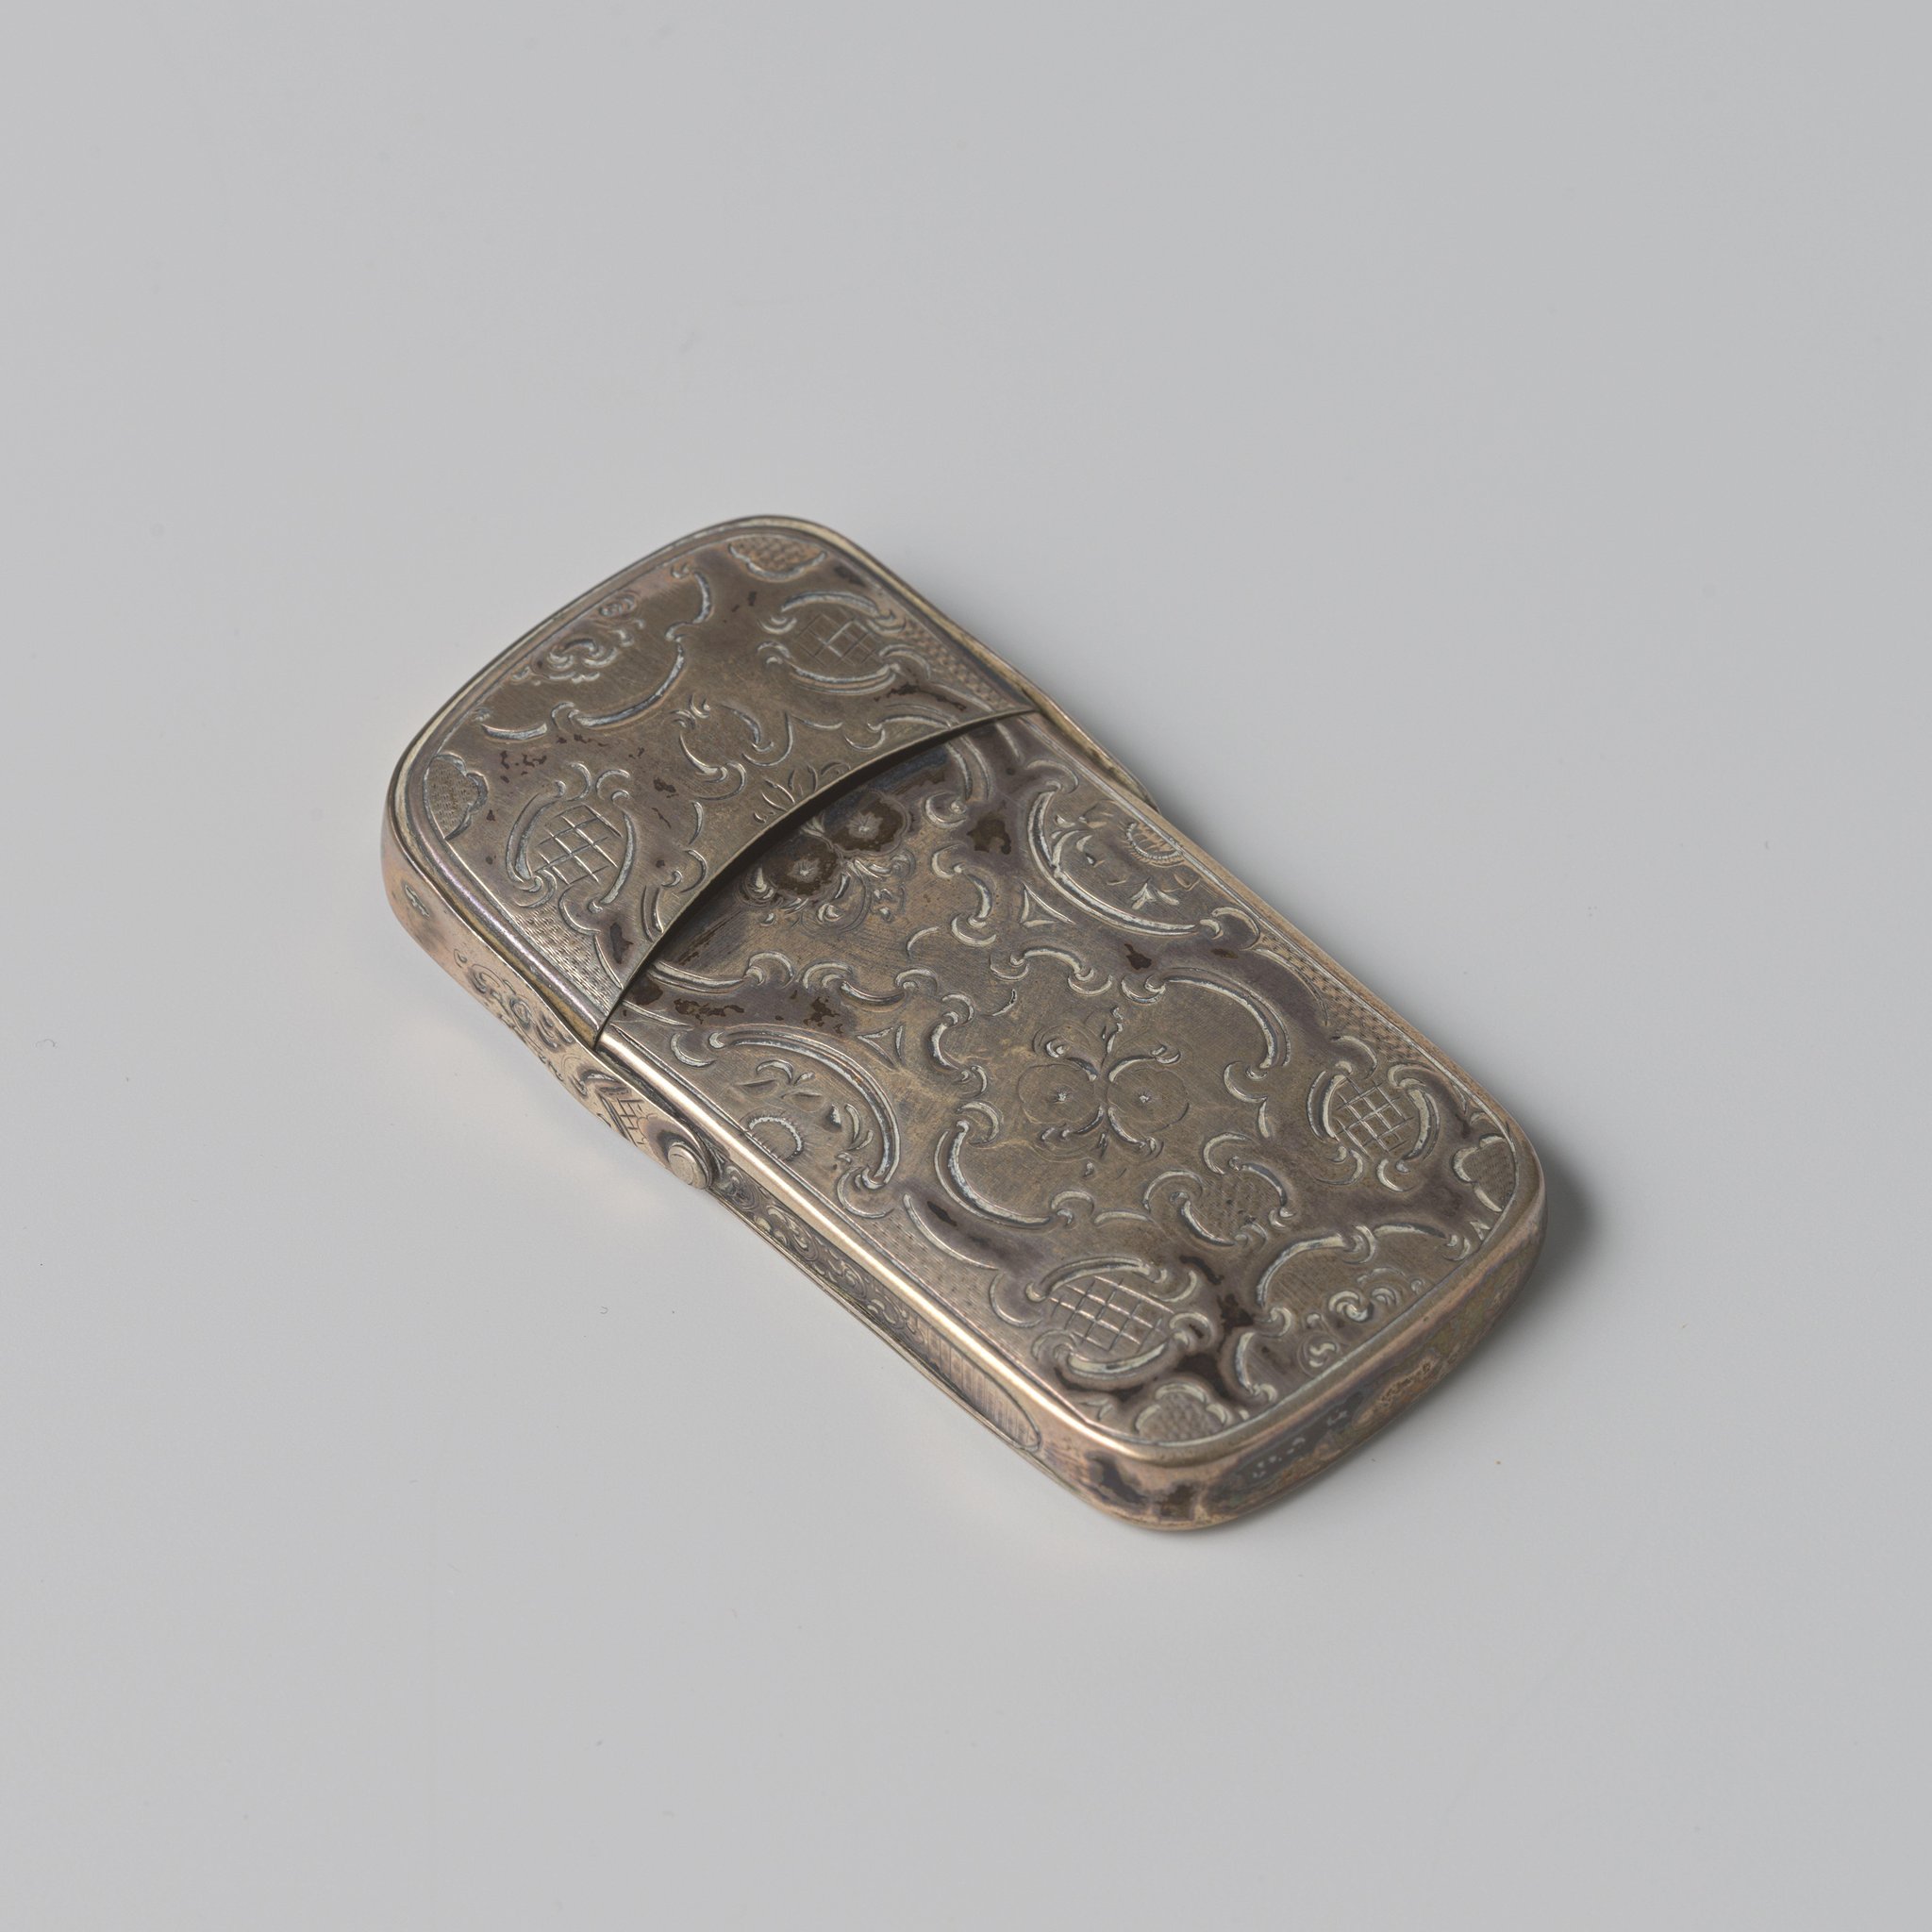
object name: speldendoos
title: Haarspeldendoos van zilver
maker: Anonymous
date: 1400-1950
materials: silver